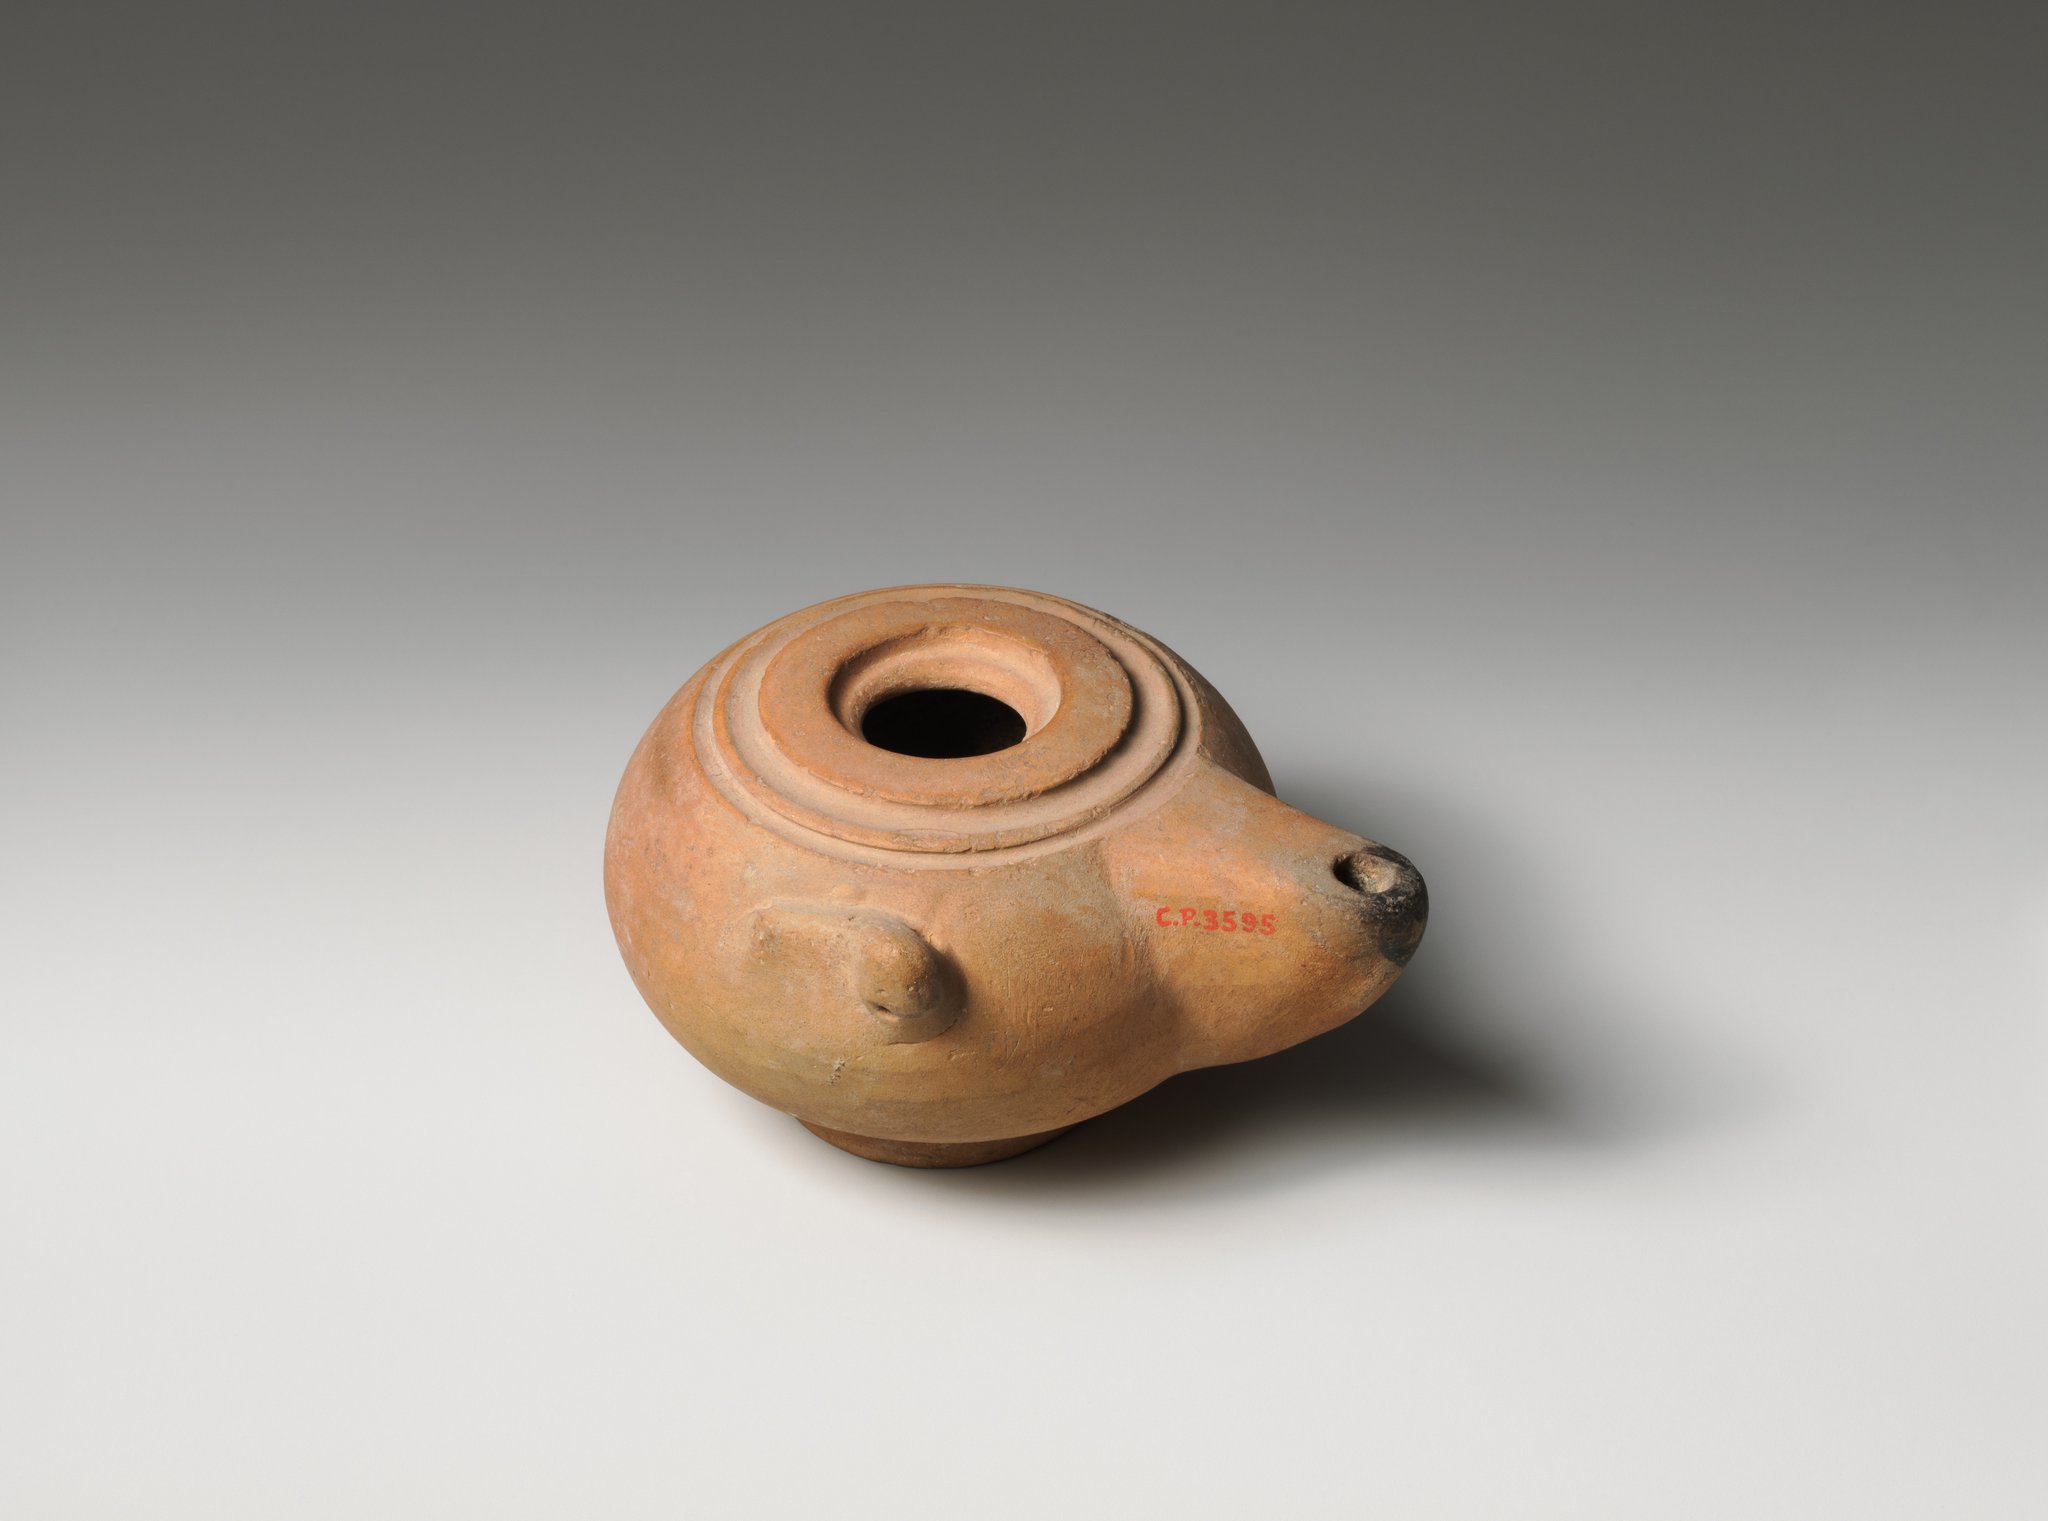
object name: lamp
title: Terracotta oil lamp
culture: greek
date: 350-250 BCE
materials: terracotta